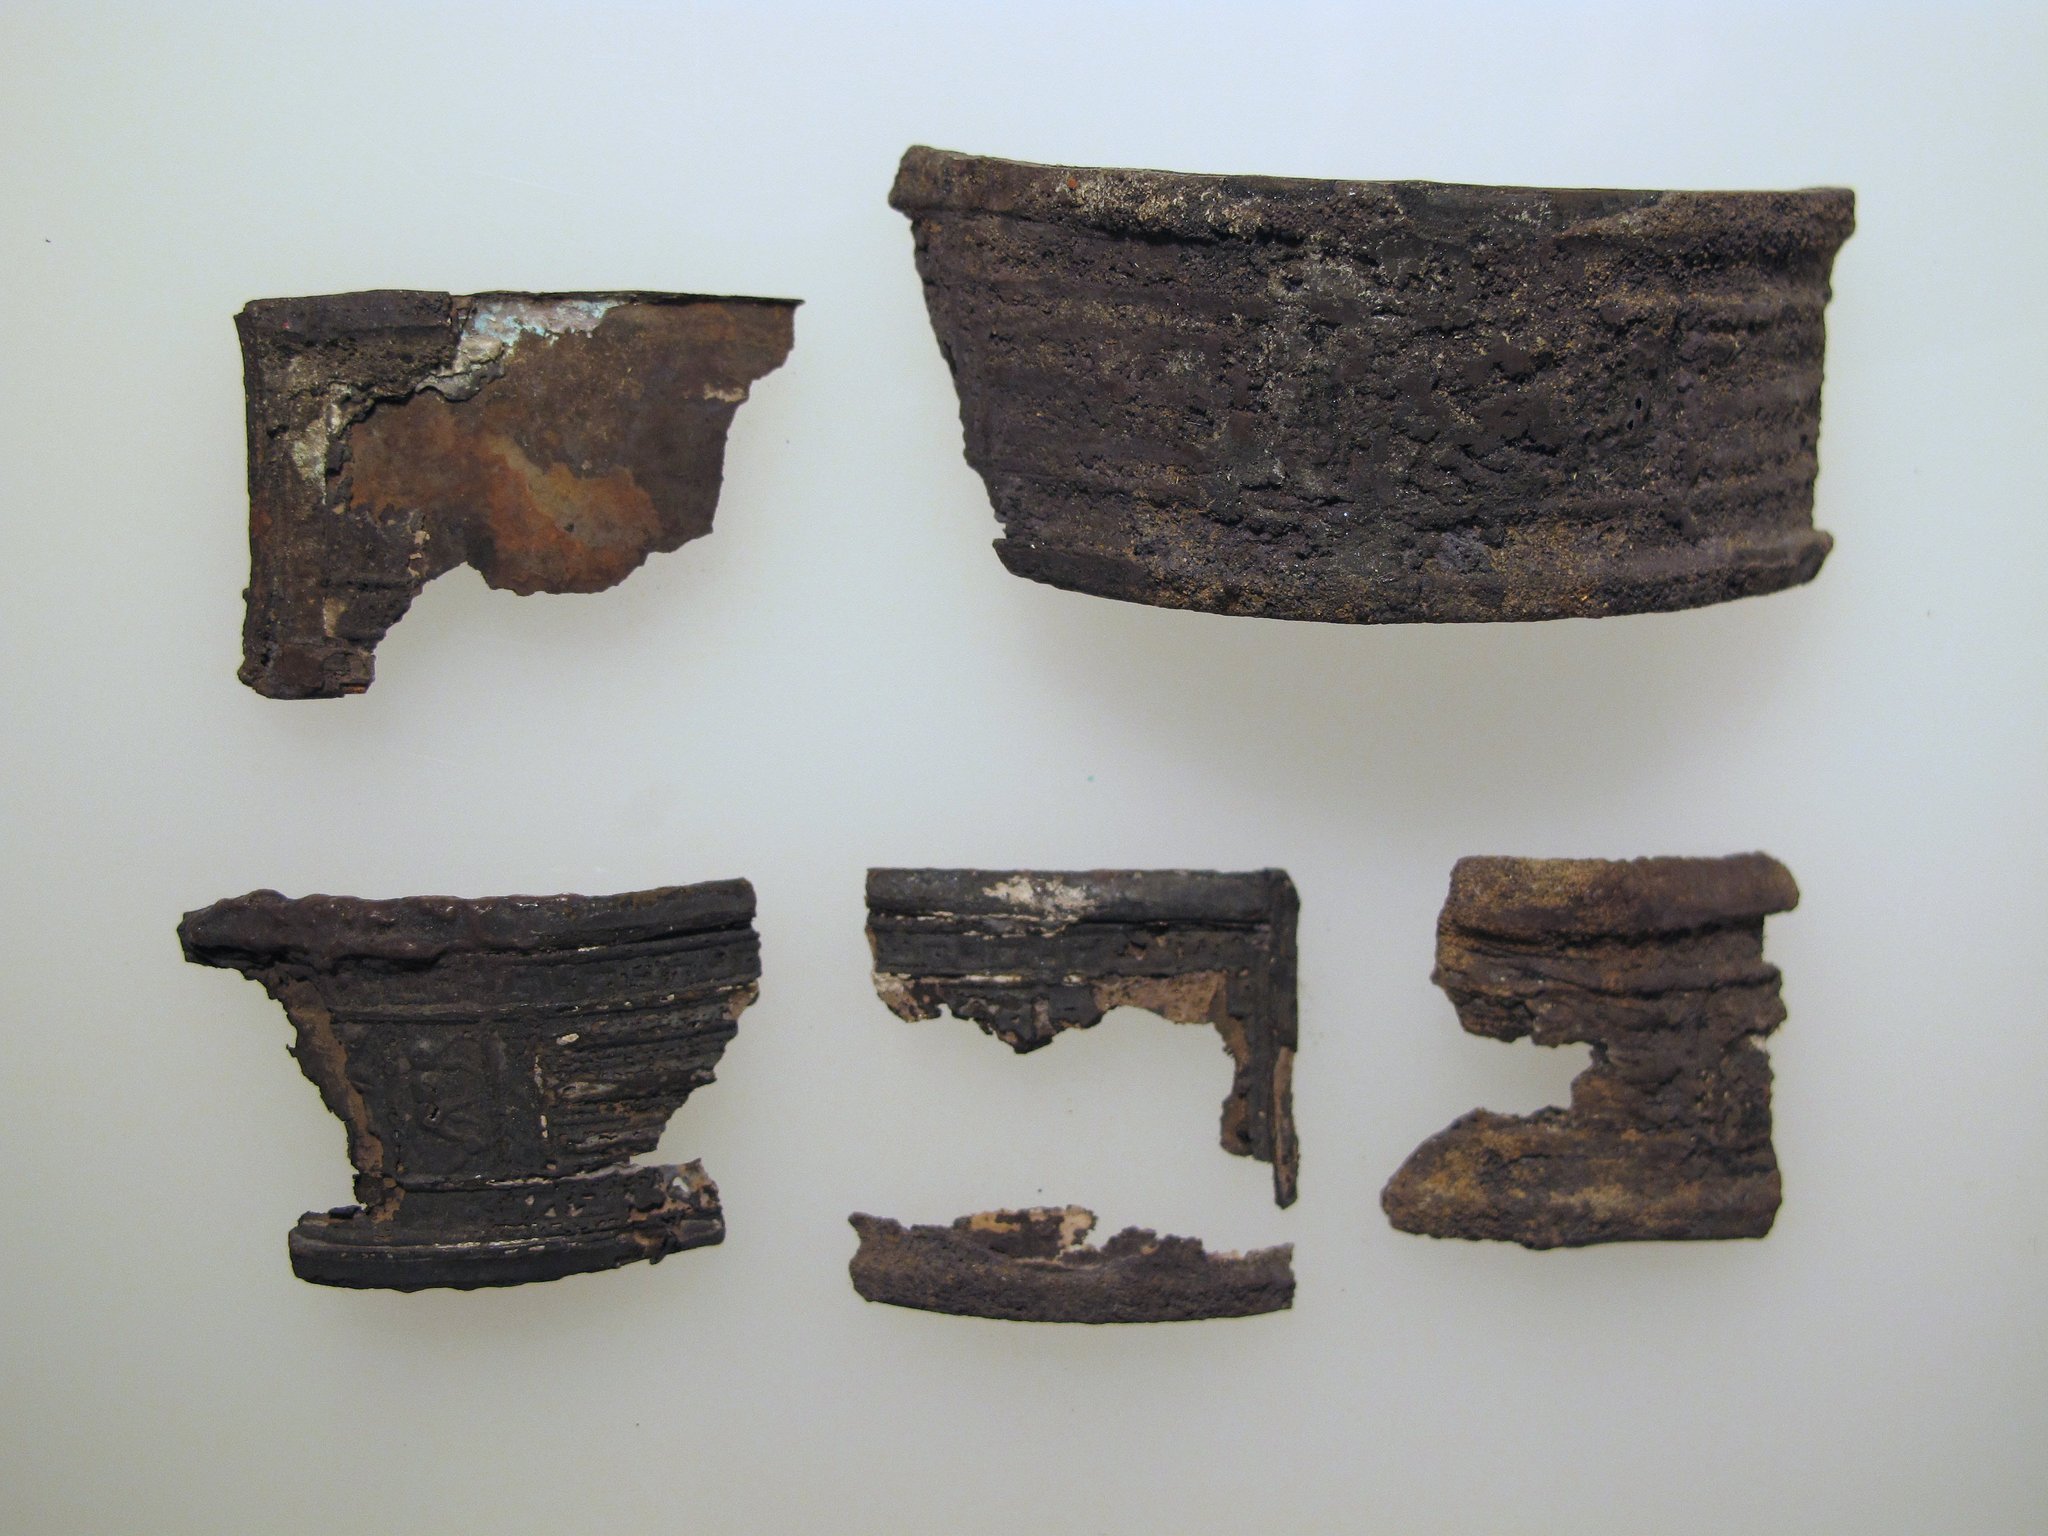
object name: bracelet fragment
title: Silver bracelet fragments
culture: cypriot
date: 3900 BCE-100 CE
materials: silver